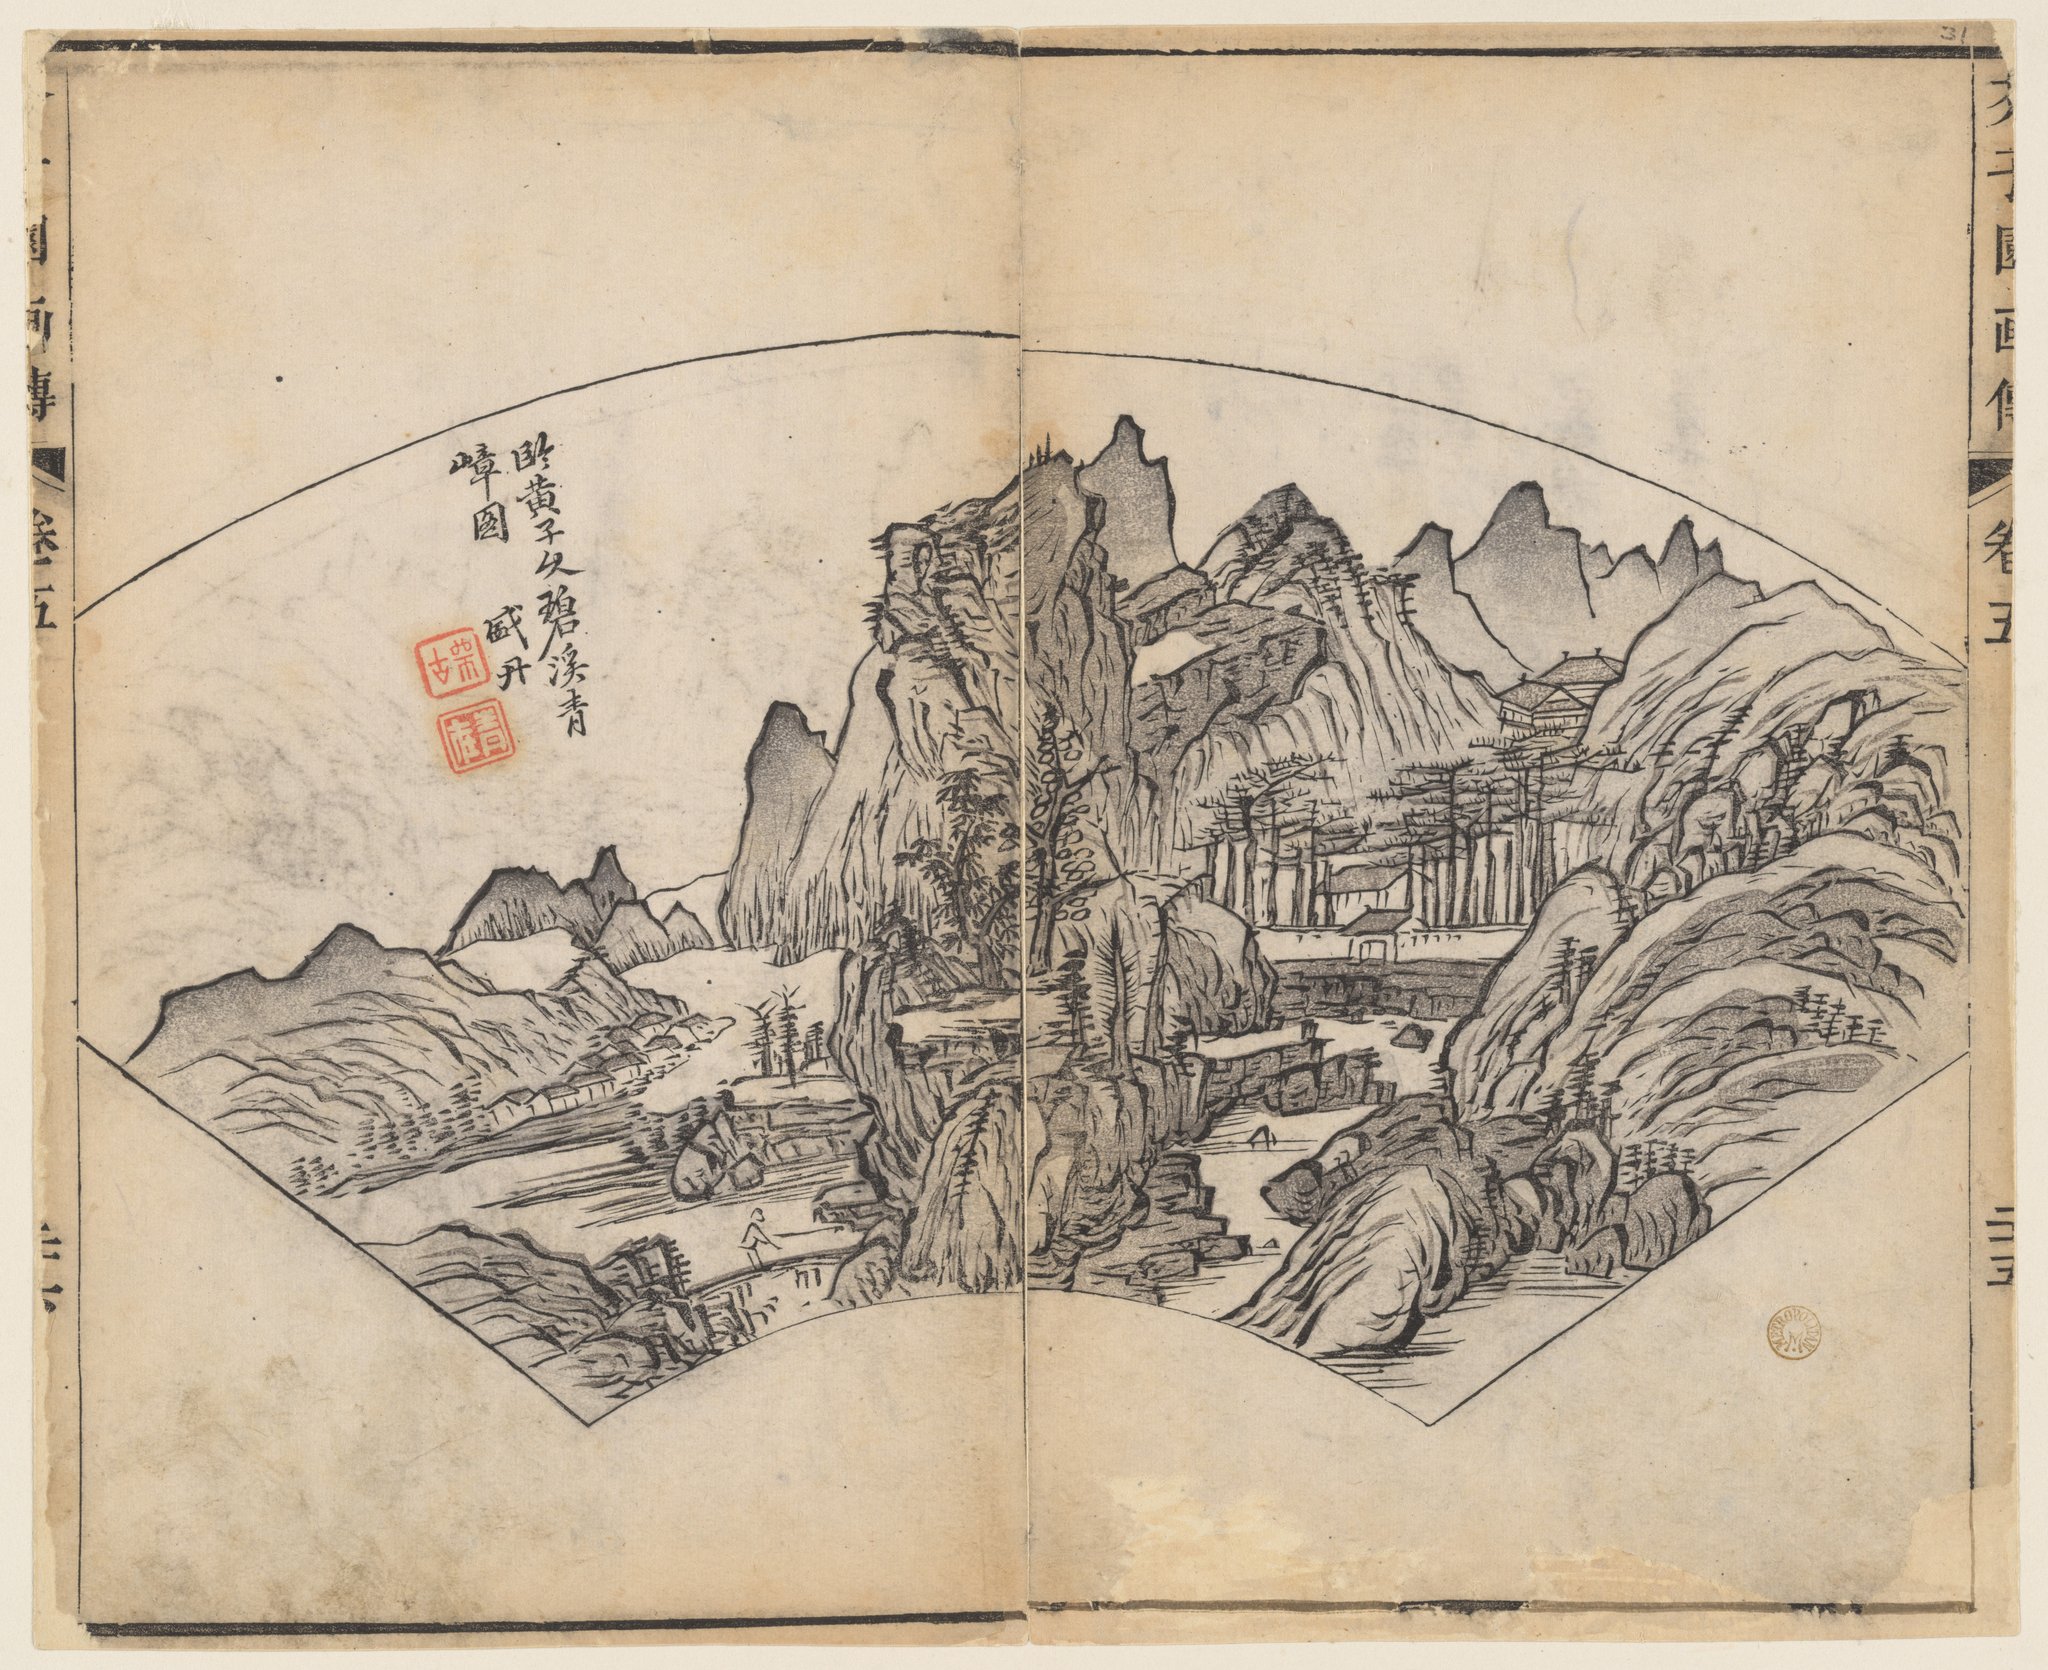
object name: print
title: Page from the Mustard Seed Garden Manual of Painting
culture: chinese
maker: wang gai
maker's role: artist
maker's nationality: chinese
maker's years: 1645-1710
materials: ink, paper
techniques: woodblock print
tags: landscapes